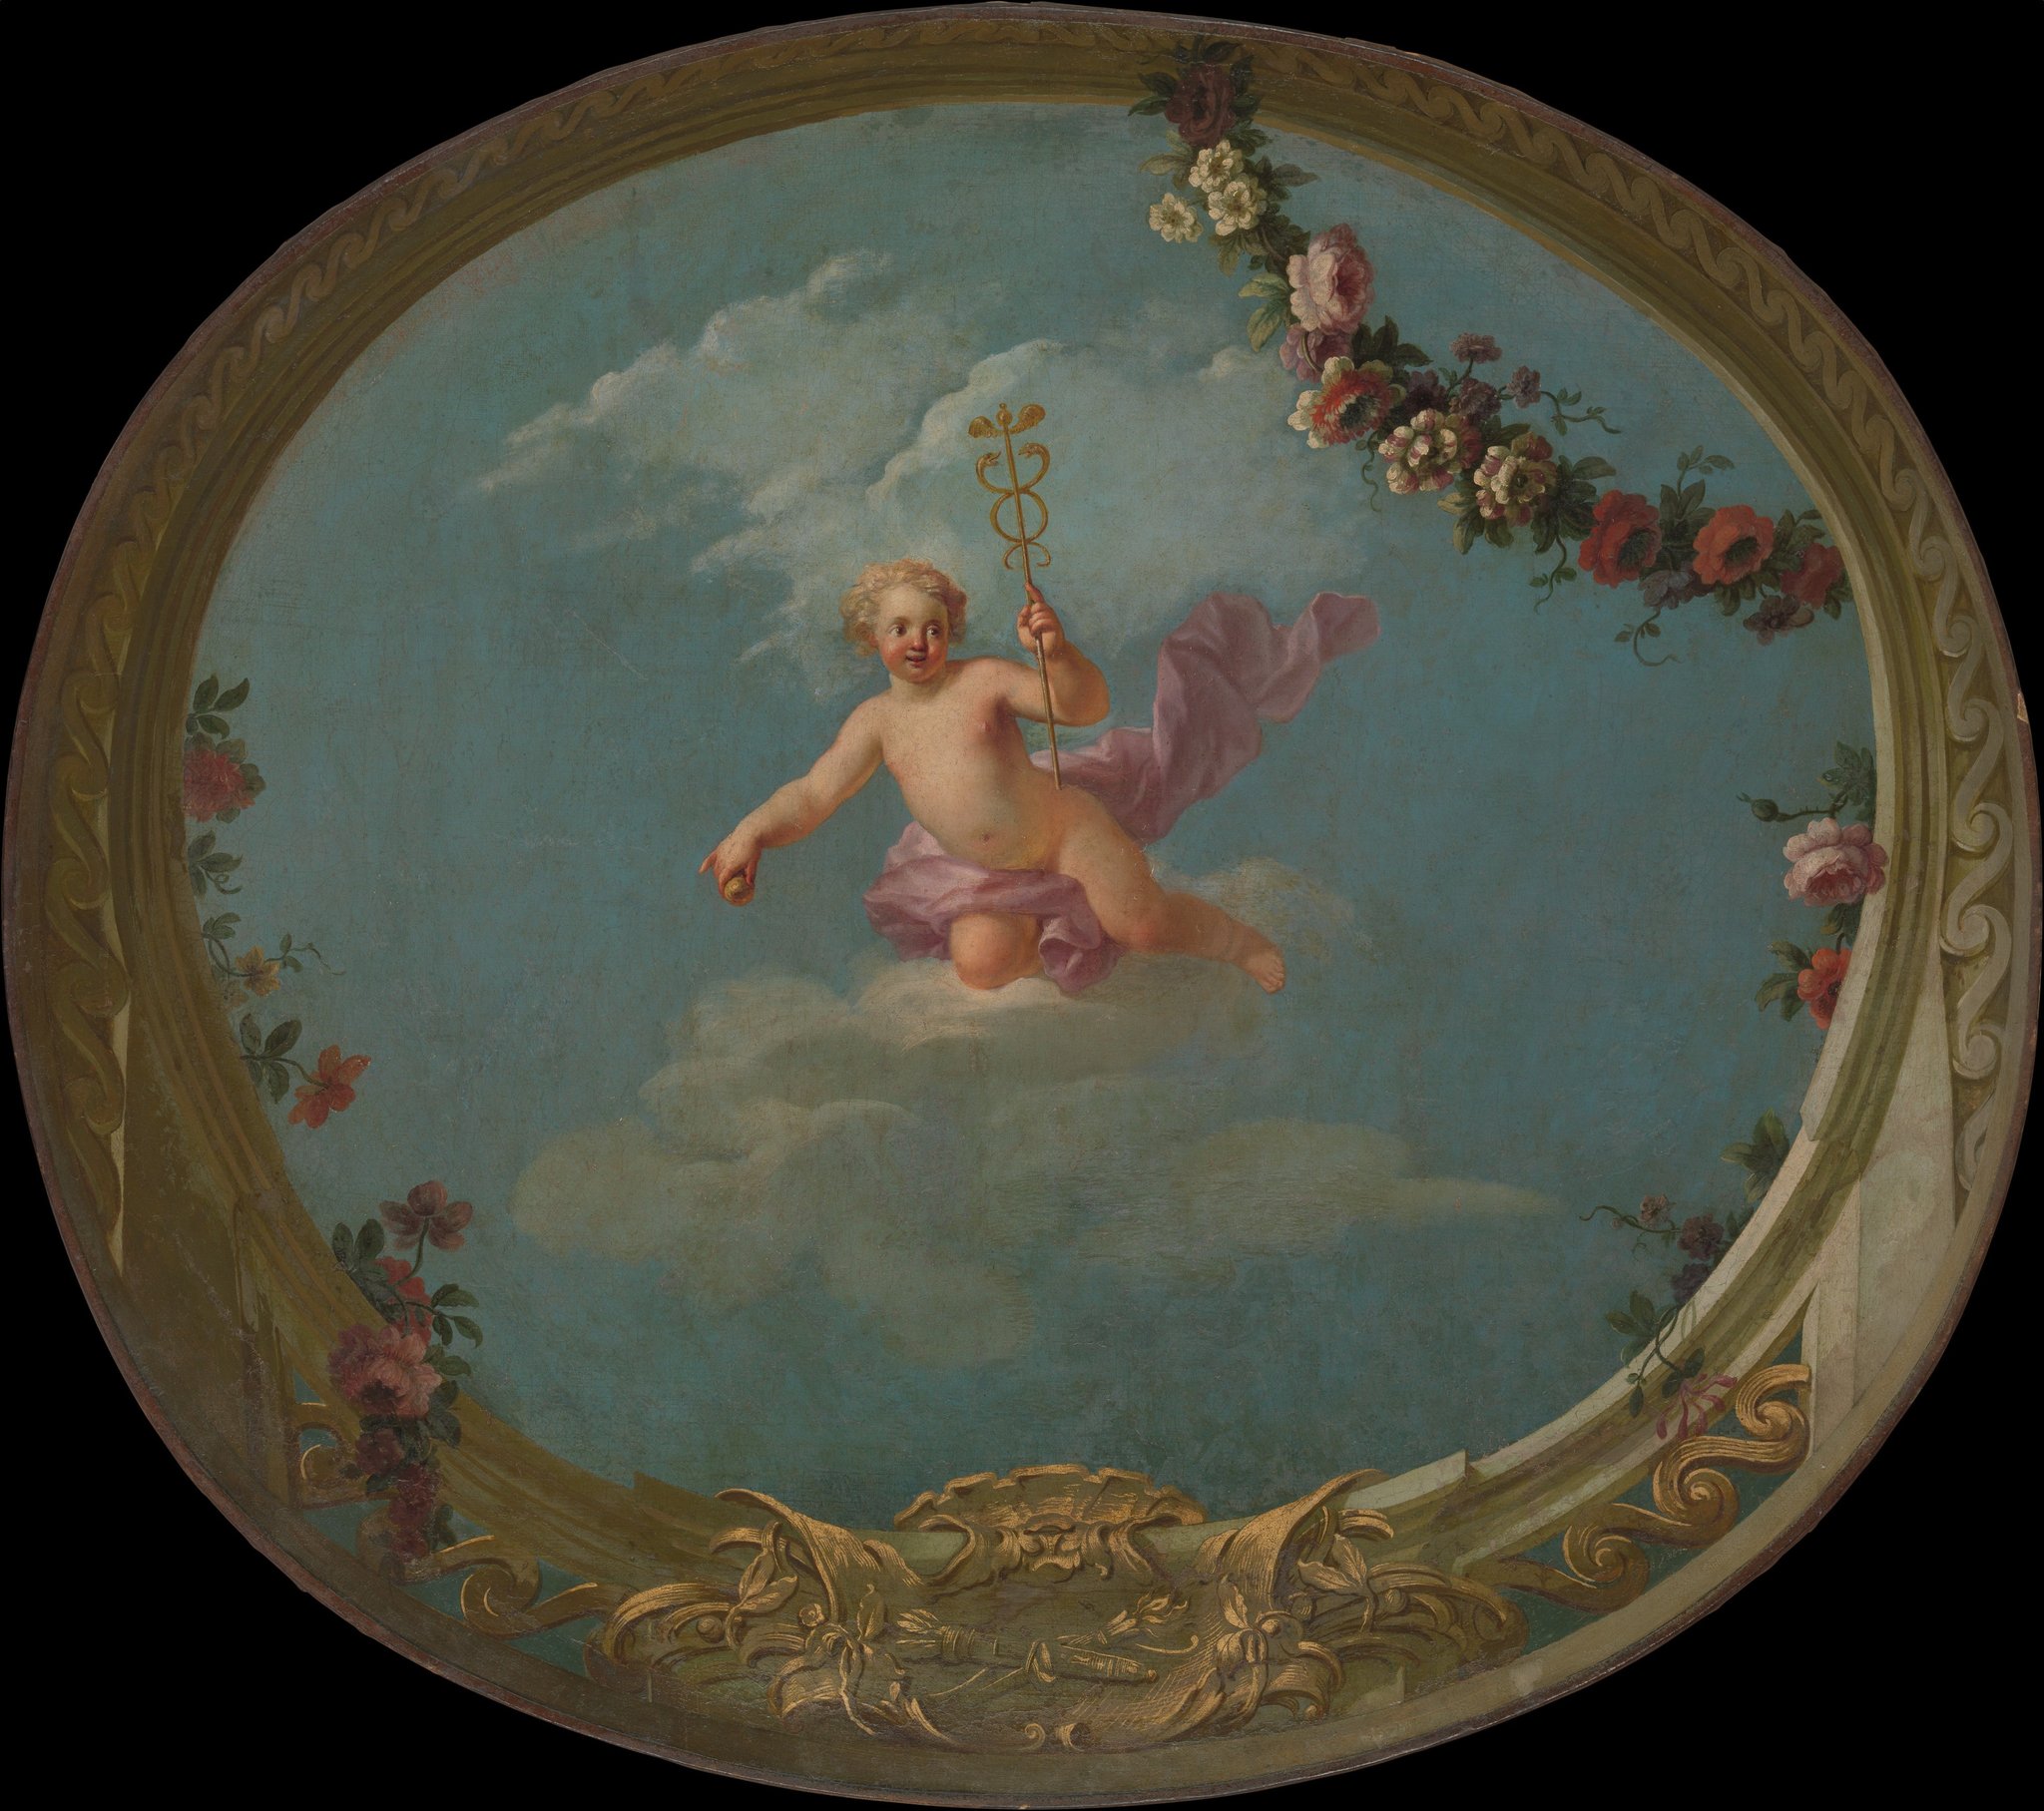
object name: canopy bed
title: Cupid as a Messenger, with Caduceus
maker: french painter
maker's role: artist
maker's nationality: french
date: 1730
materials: canvas, oil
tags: garlands,cupid